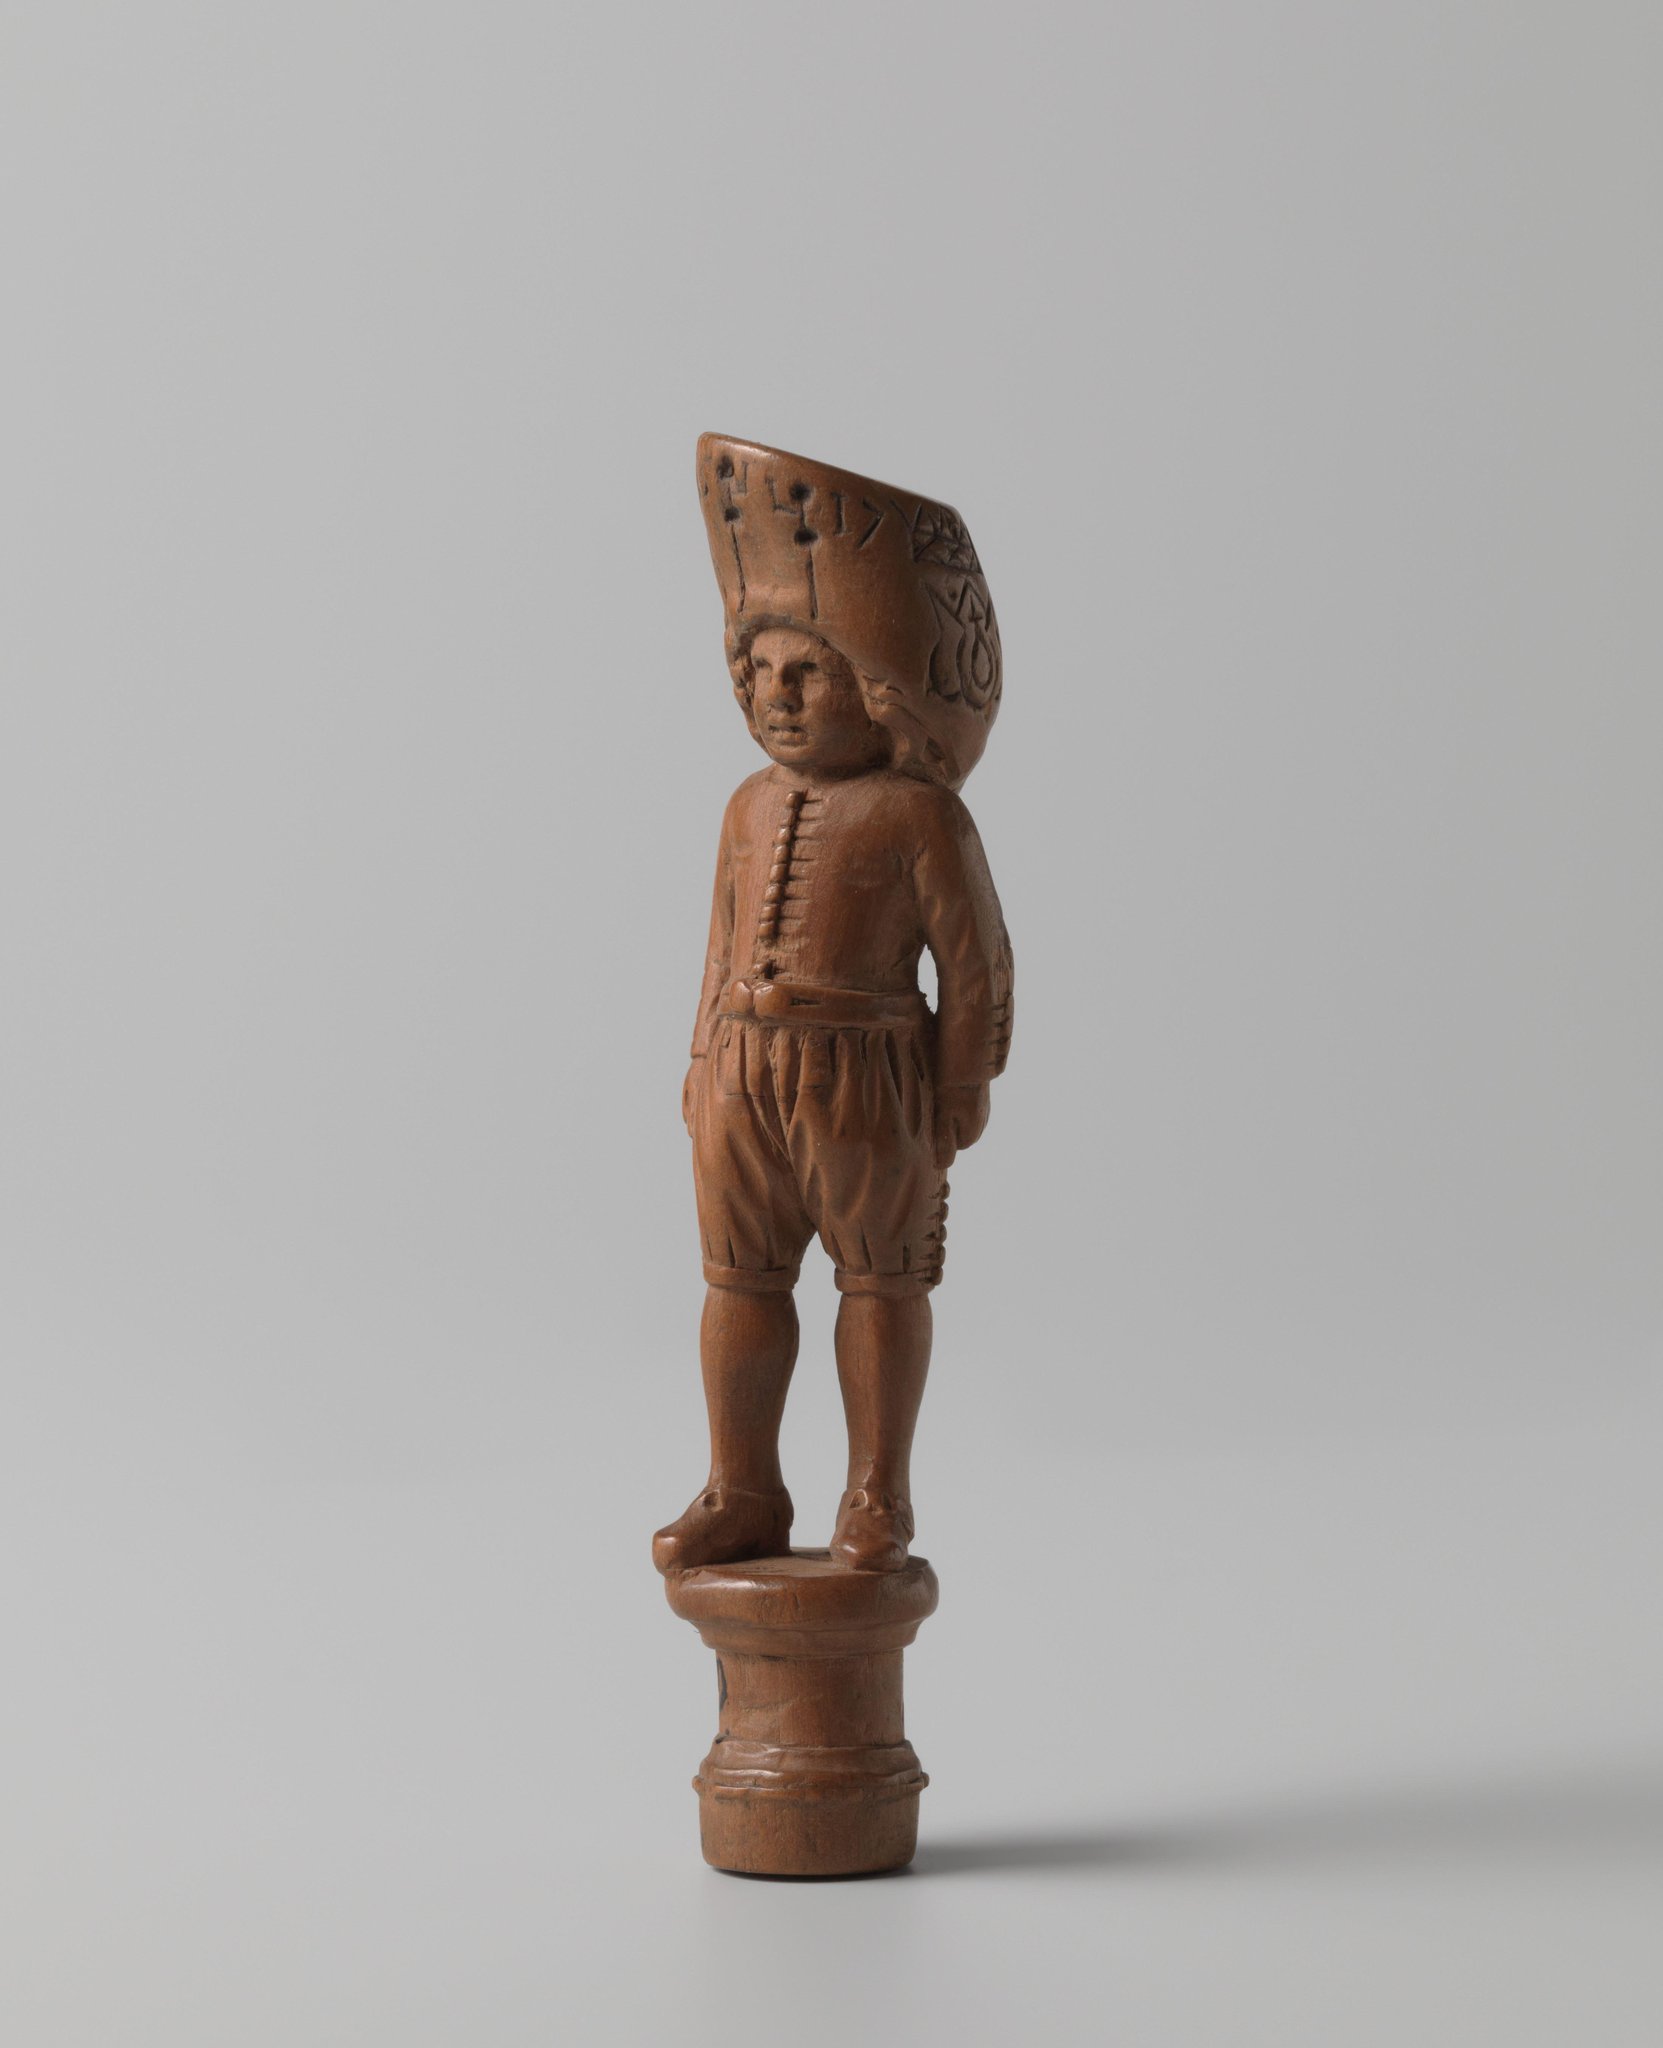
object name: sculpture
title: Corn-Carrier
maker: Anonymous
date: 1715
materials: wood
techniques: cutting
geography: northern netherlands